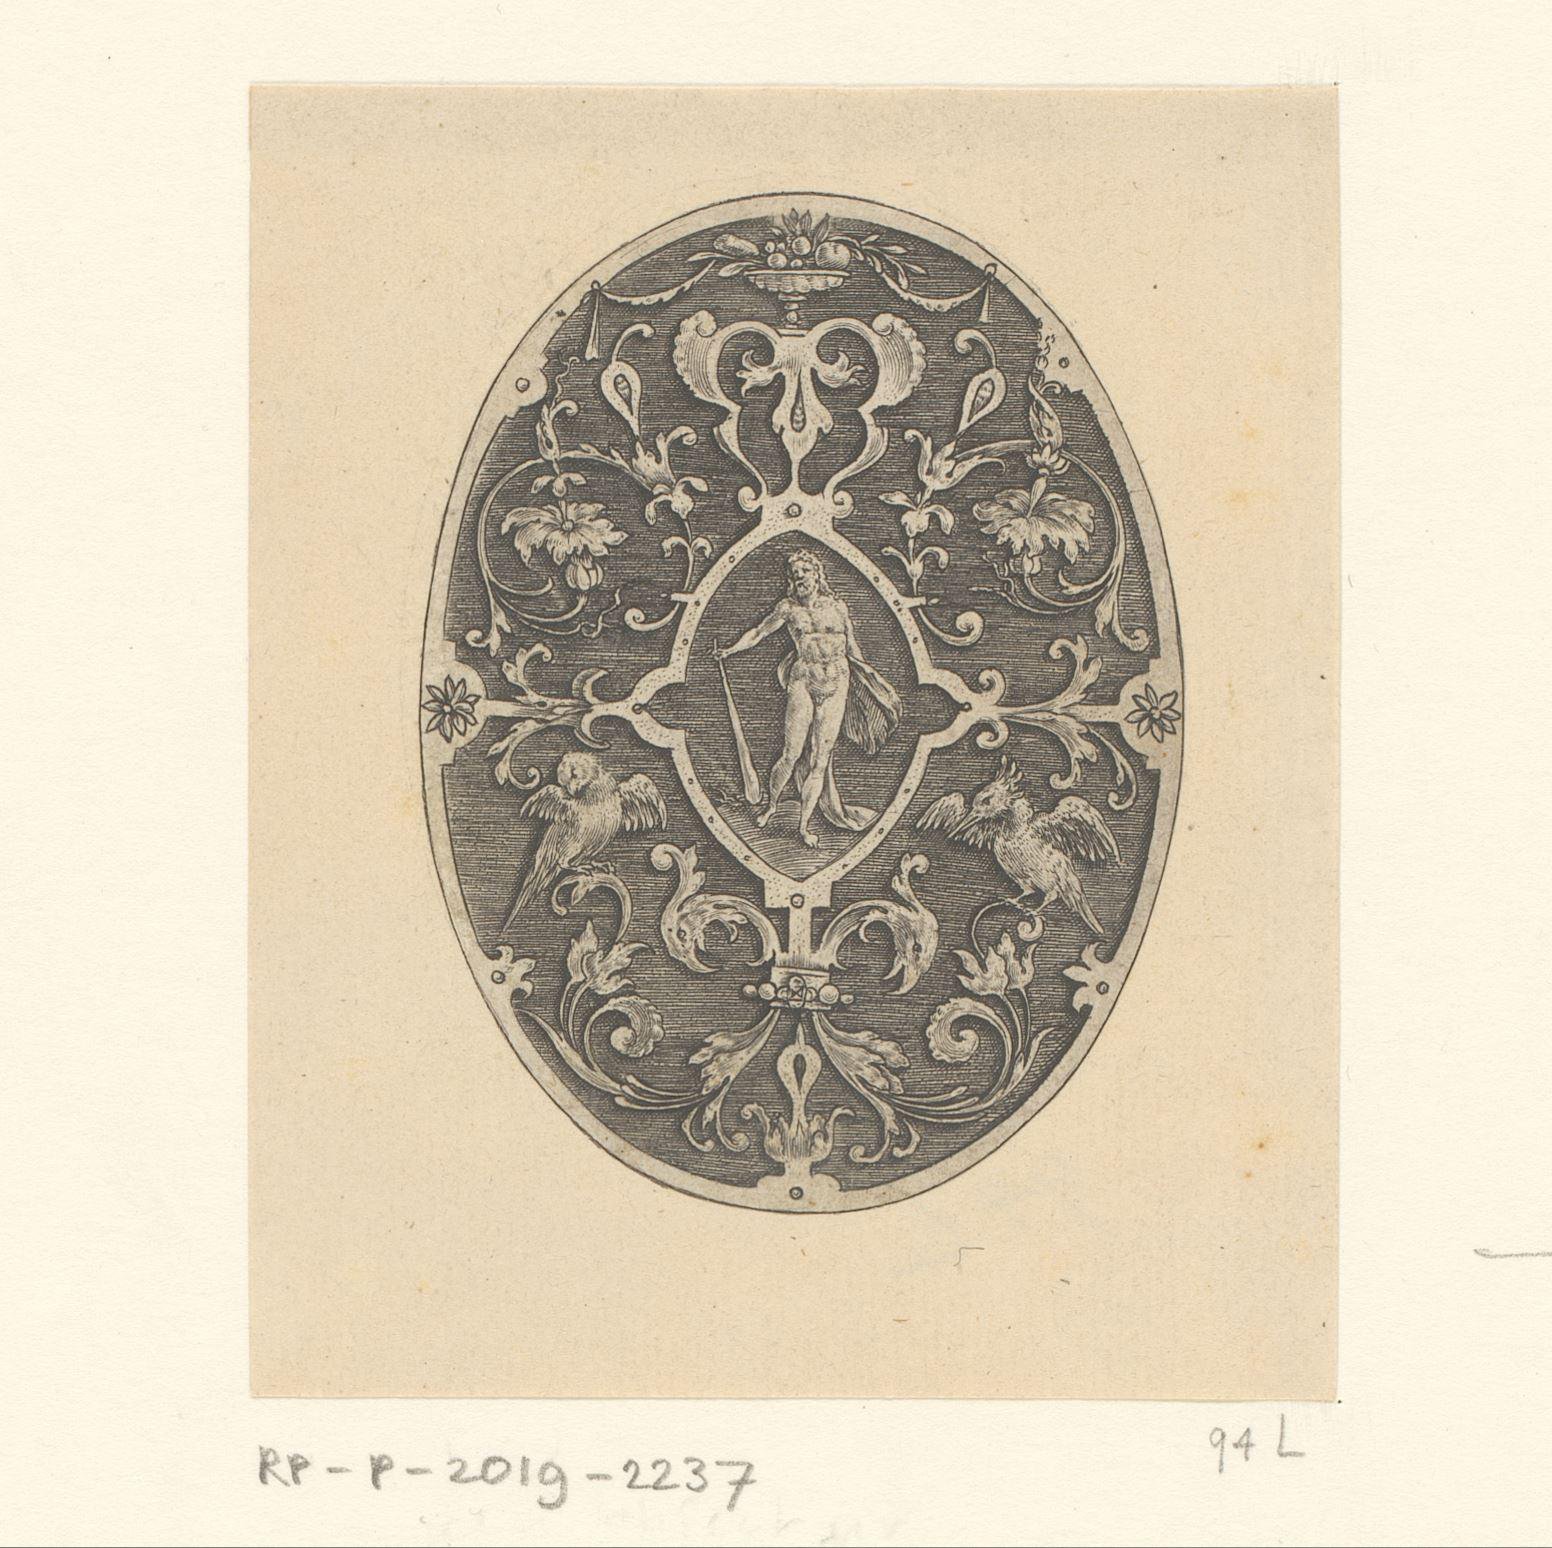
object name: ornament print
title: Vlakdecoraties met grotesken op een gearceerde achtergrond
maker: philips galle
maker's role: print maker, publisher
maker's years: 1537-1612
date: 1547-1612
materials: paper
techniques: engraving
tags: (story of) hercules (heracles)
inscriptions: collector's mark: Lugt 2228